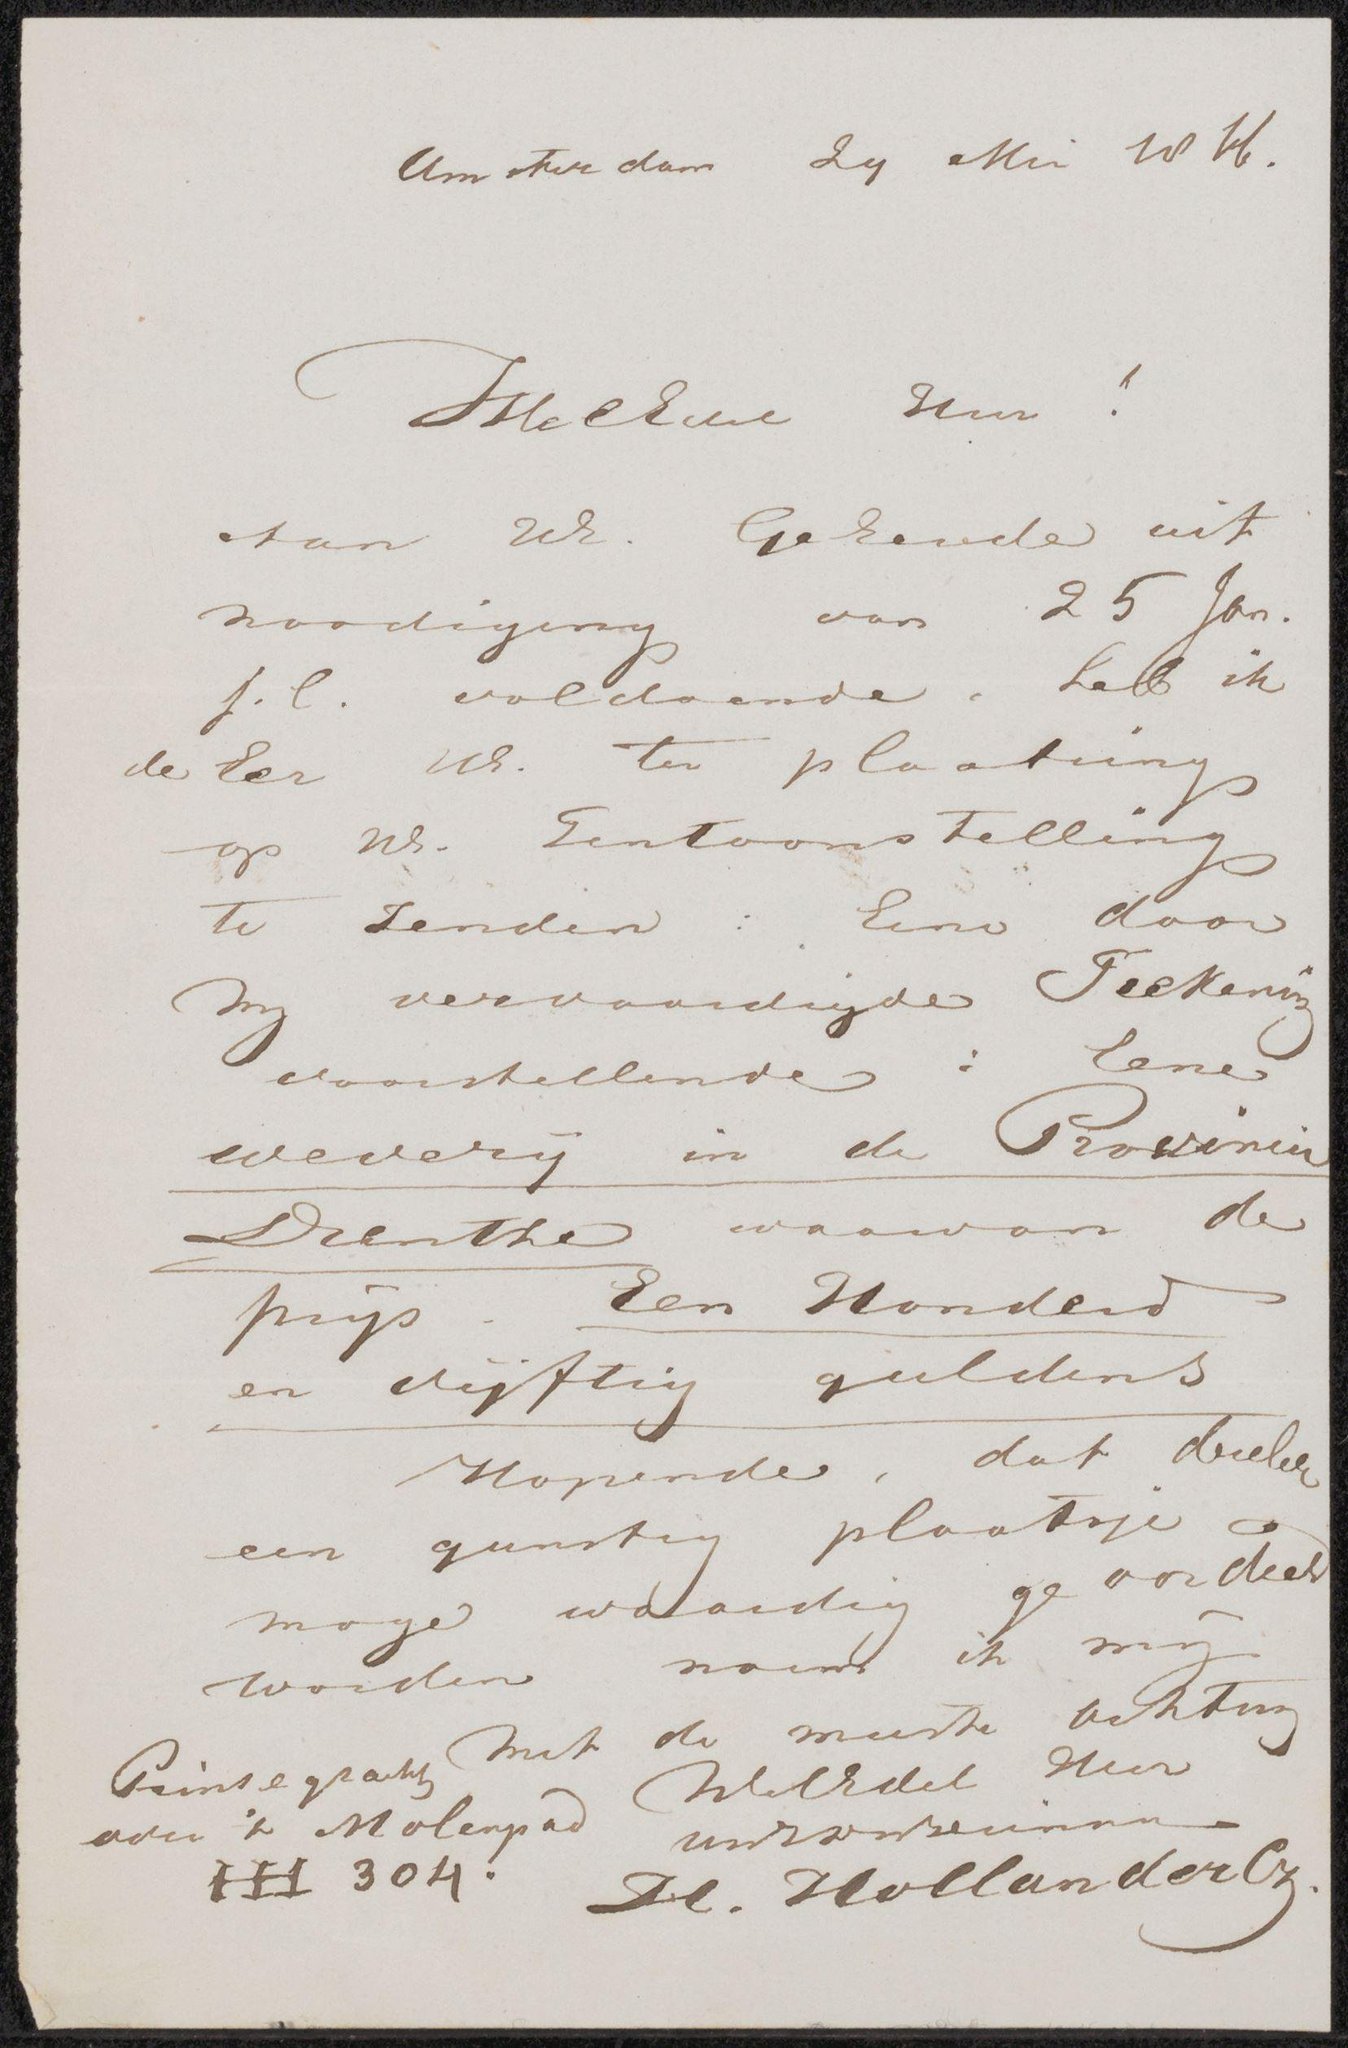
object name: letter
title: Brief aan anoniem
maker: hendrik hollander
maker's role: draughtsman, painter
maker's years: 1823-1884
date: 1866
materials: ink, paper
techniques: pen, writing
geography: amsterdam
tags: drawing, exhibition ~ art, money